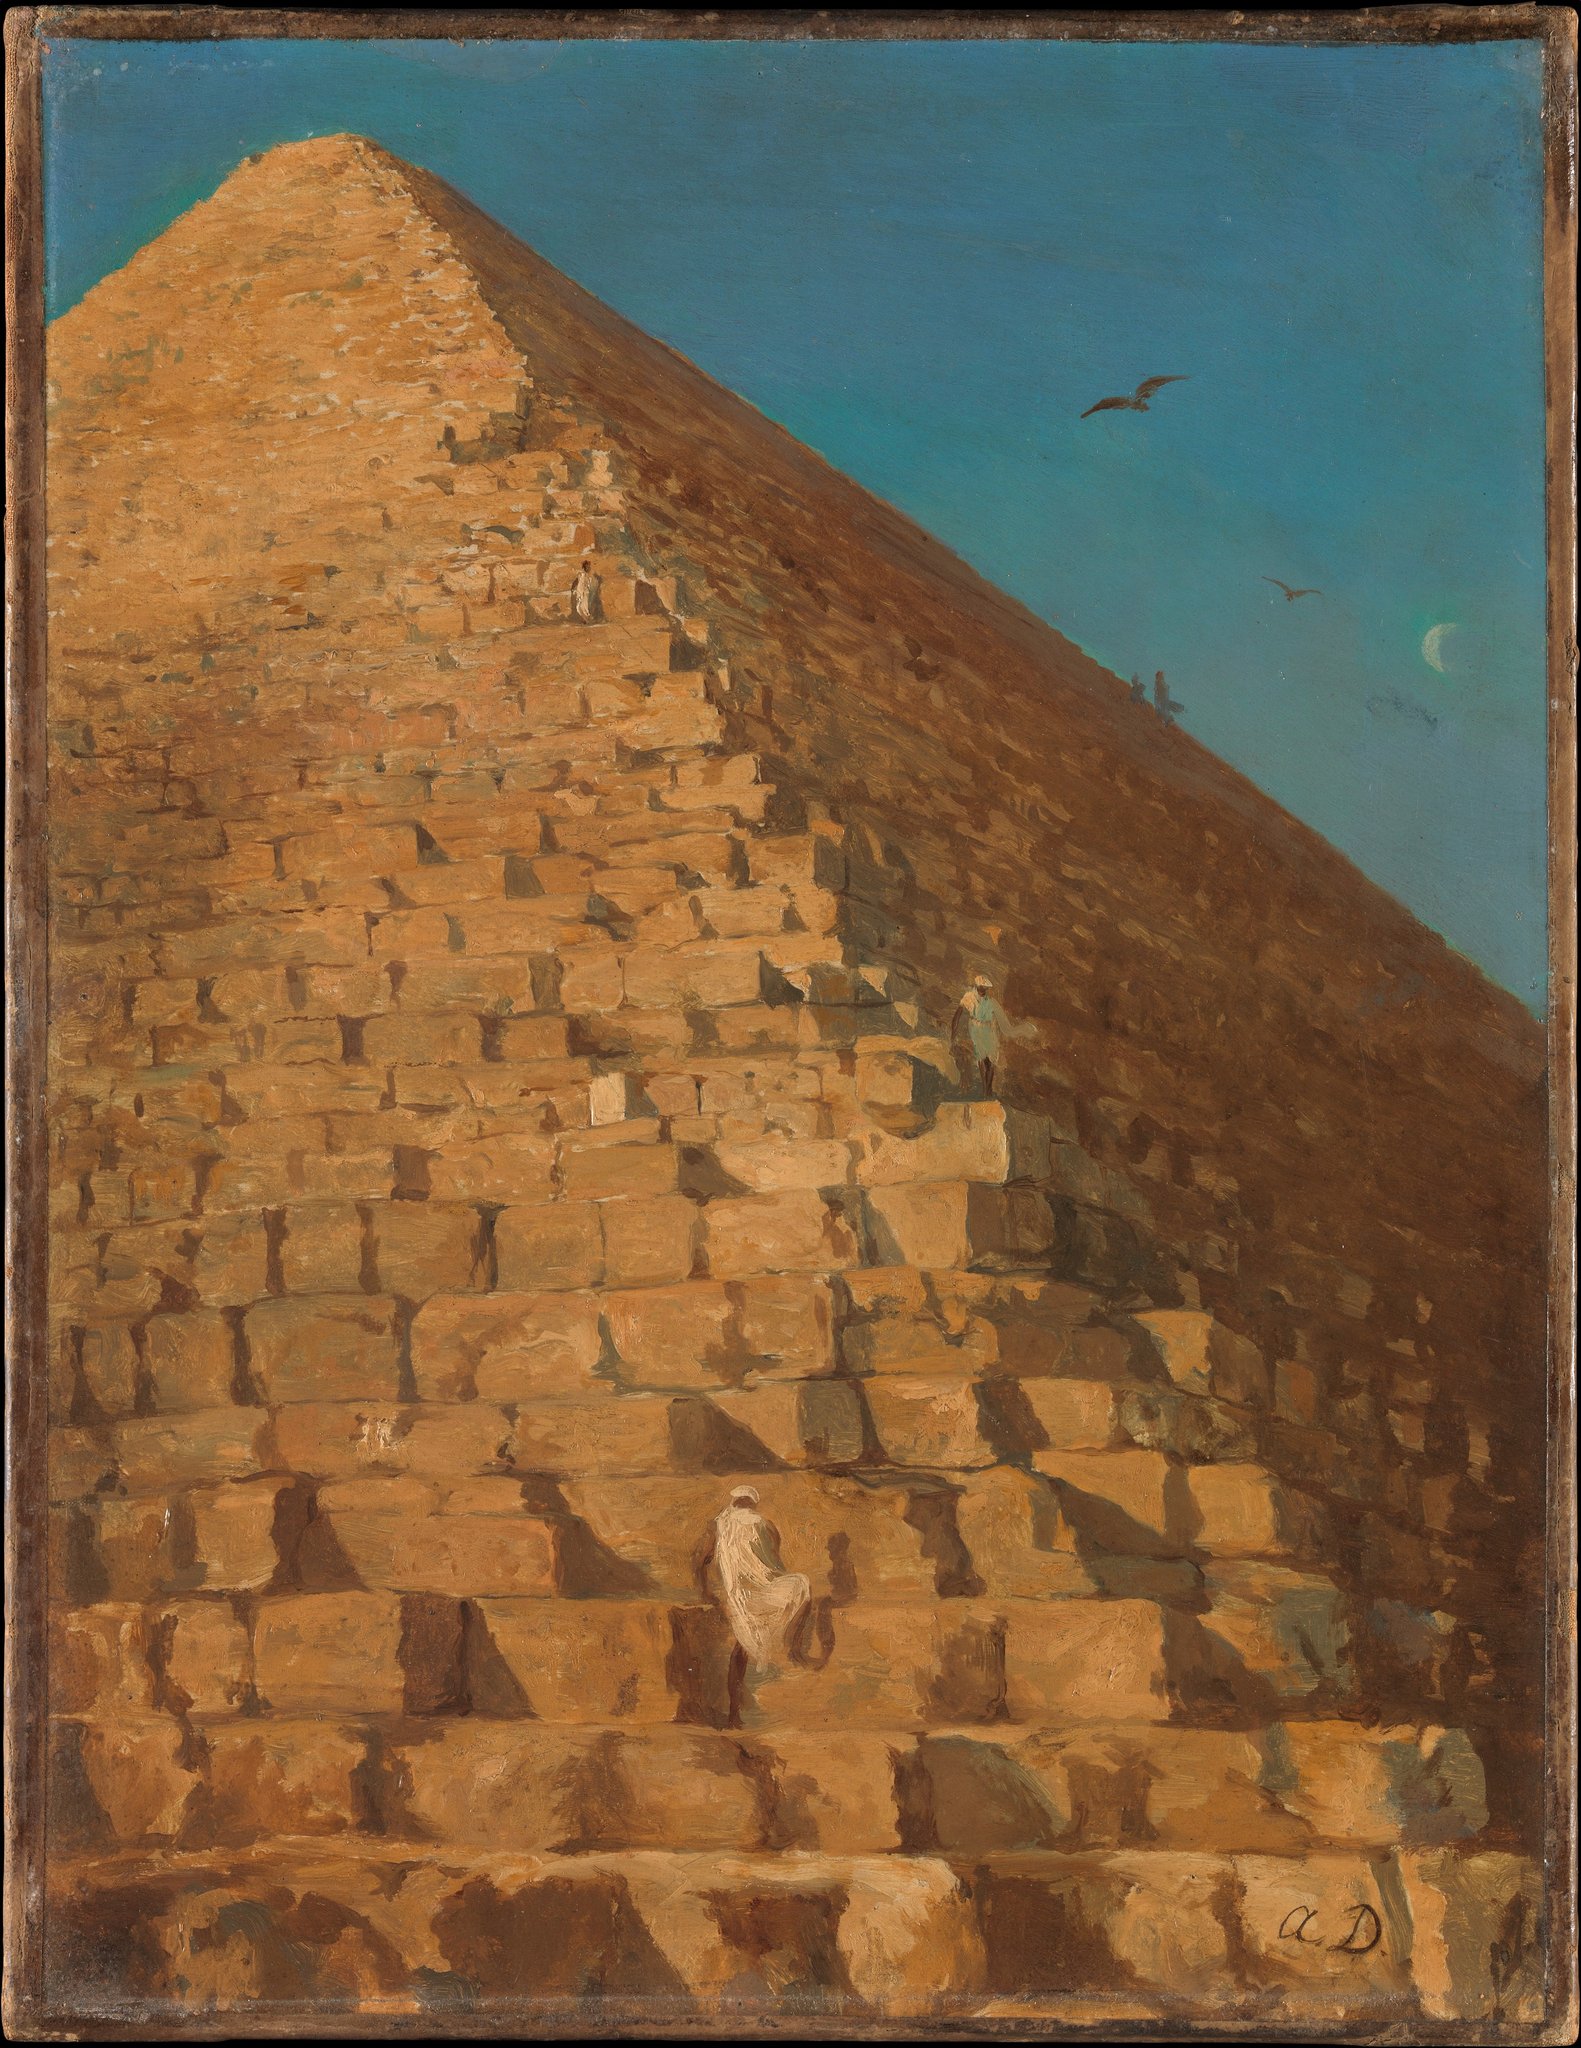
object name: painting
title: The Great Pyramid, Giza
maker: adrien dauzats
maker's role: artist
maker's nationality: french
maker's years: 1804-1868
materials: canvas, oil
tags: pyramids,orientalist